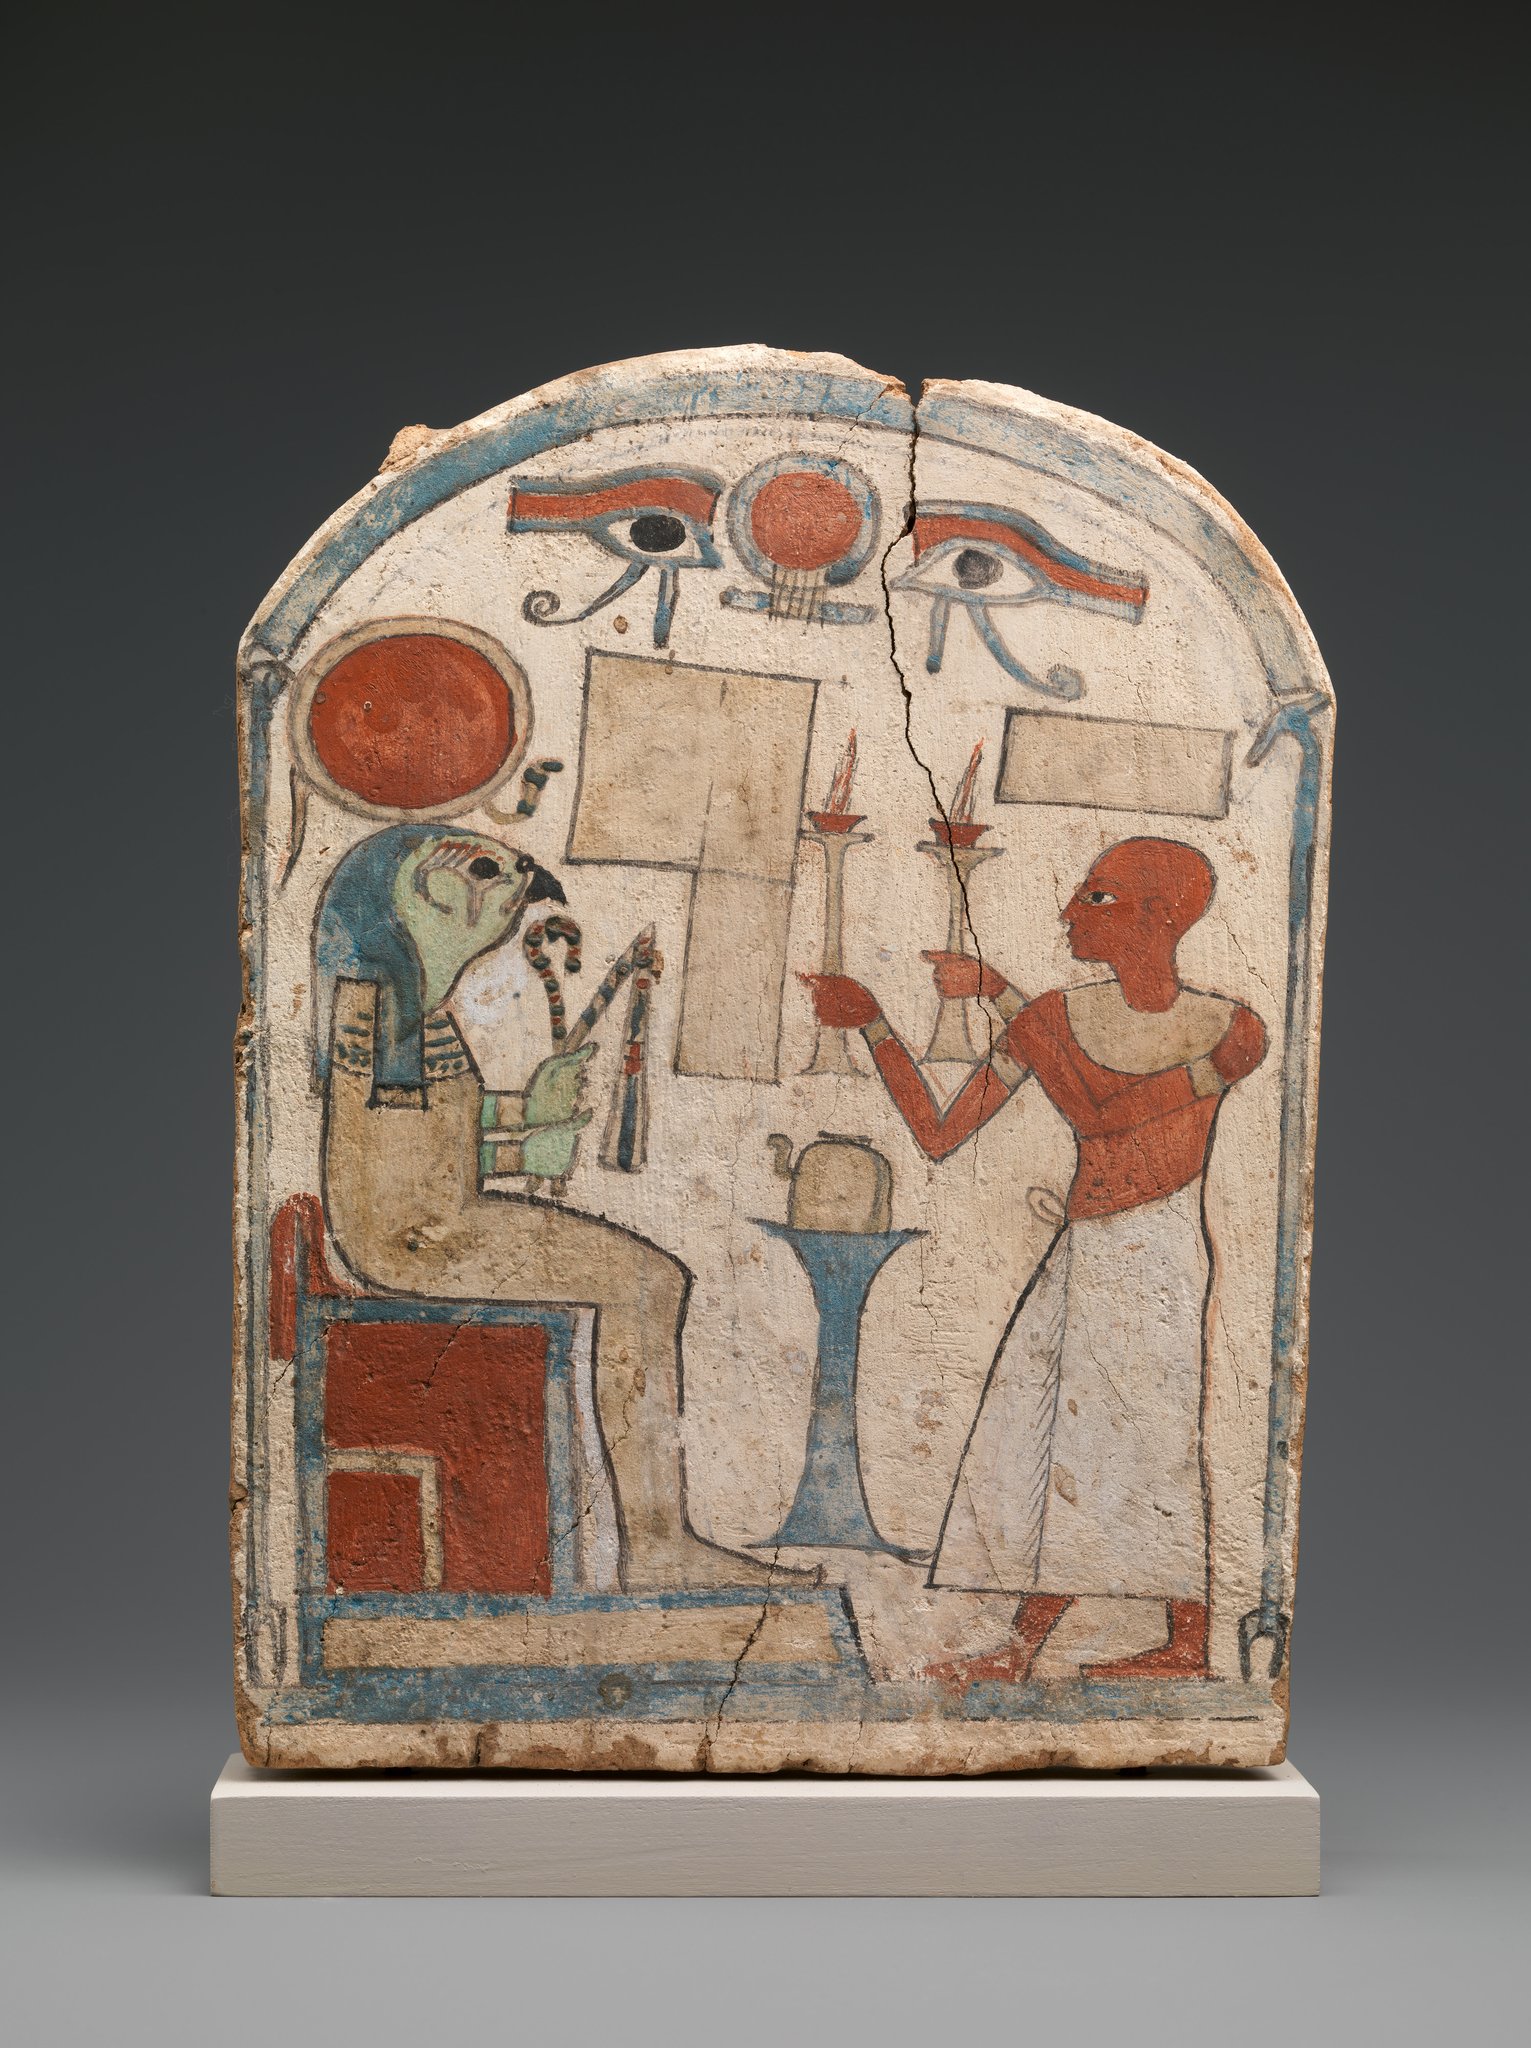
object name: stela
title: Stela with man offering to Re-Harakhty, unfinished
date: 712-663 BCE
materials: gesso, paint, wood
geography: egypt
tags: men